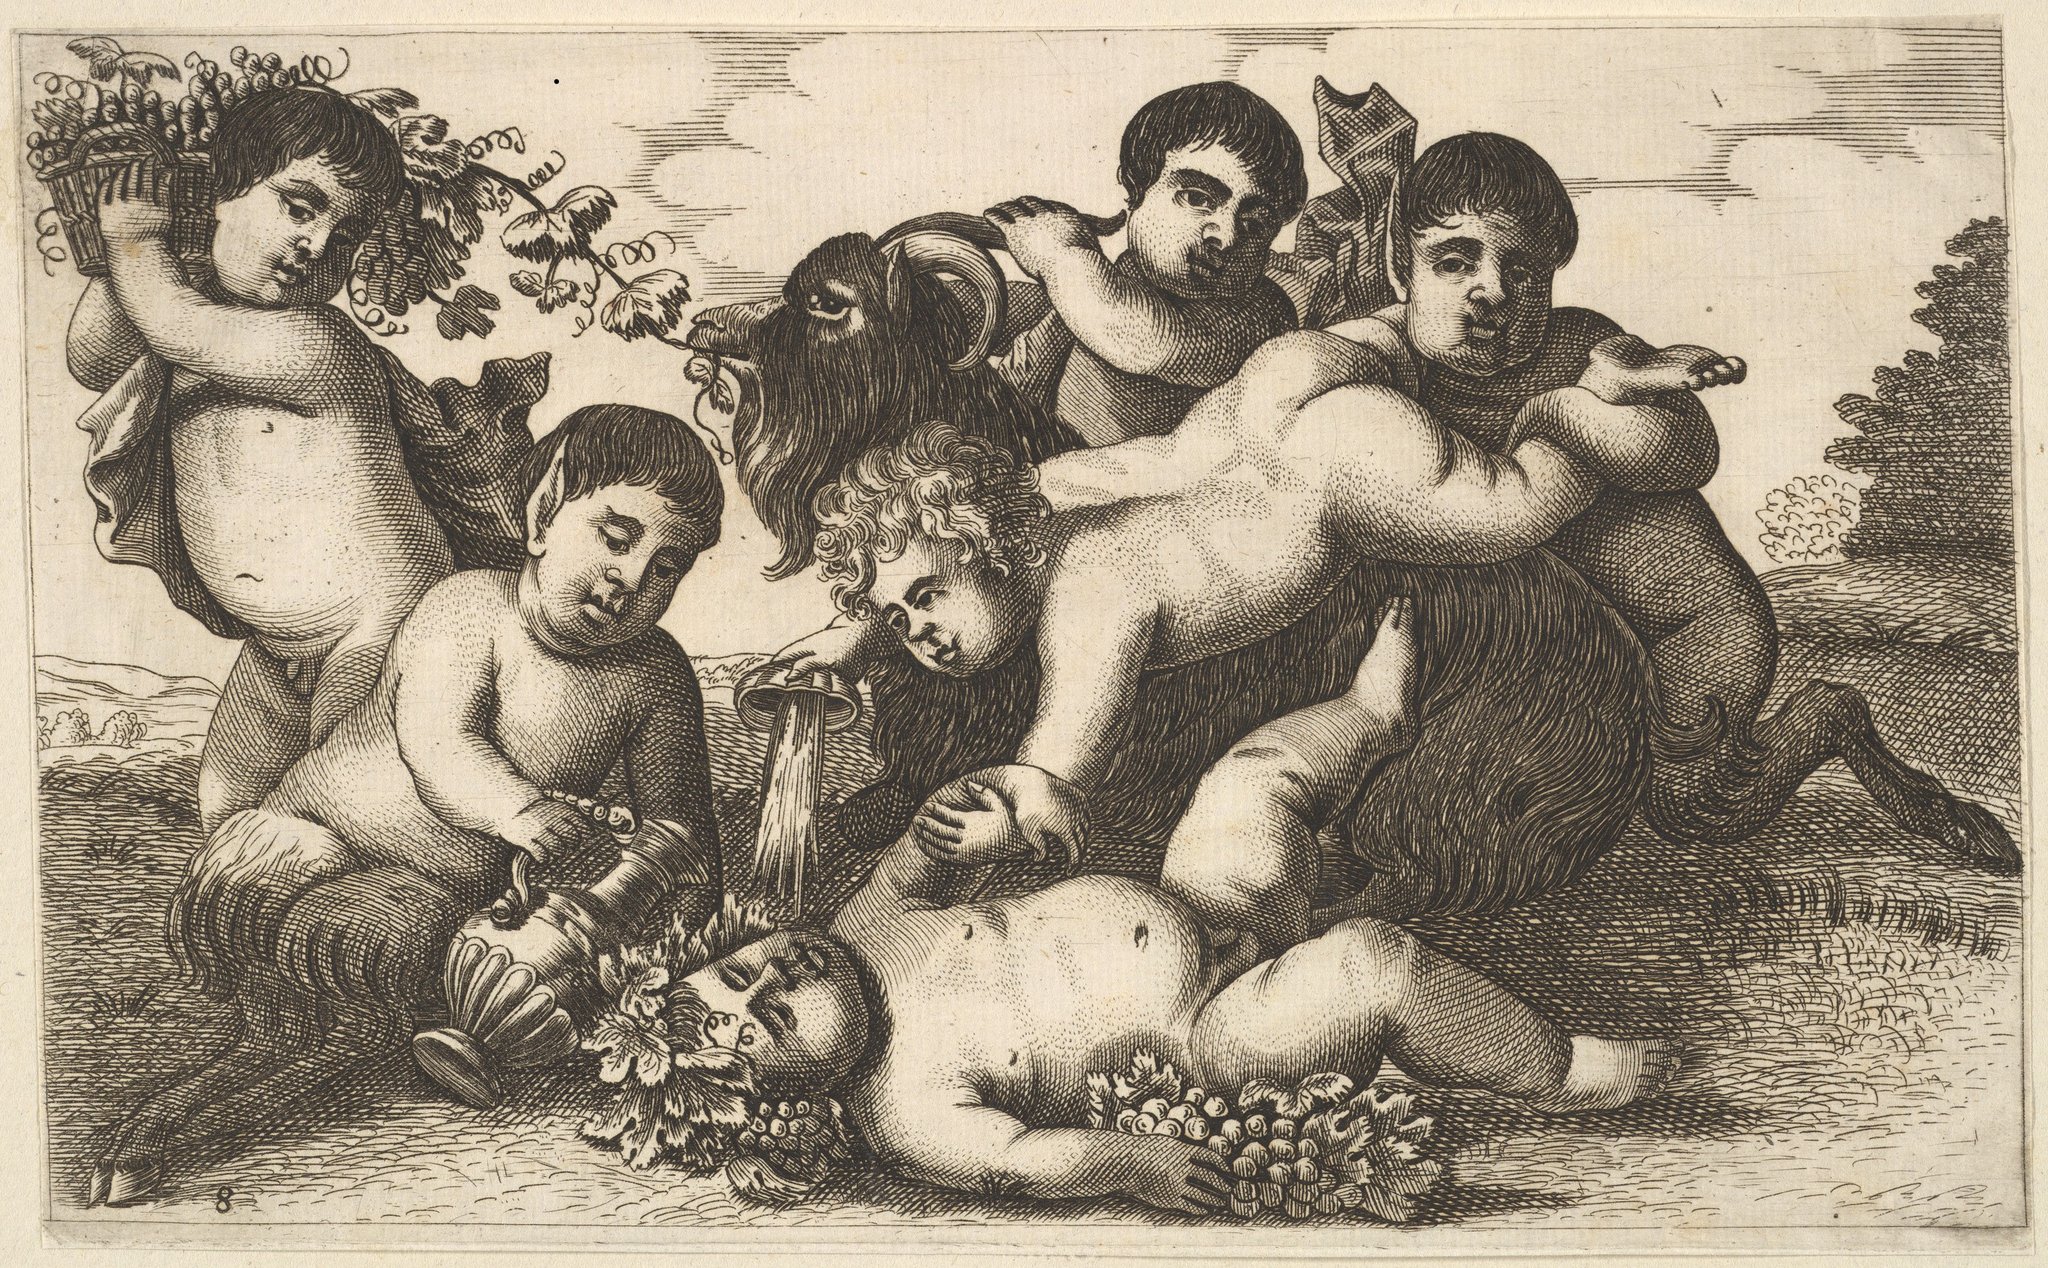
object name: print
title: Four boys, two satyrs, and a goat (copy in reverse)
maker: wenceslaus hollar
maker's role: artist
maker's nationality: bohemian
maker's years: 1607-1677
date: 1601-1700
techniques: engraving, etching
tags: boys,satyrs,goats